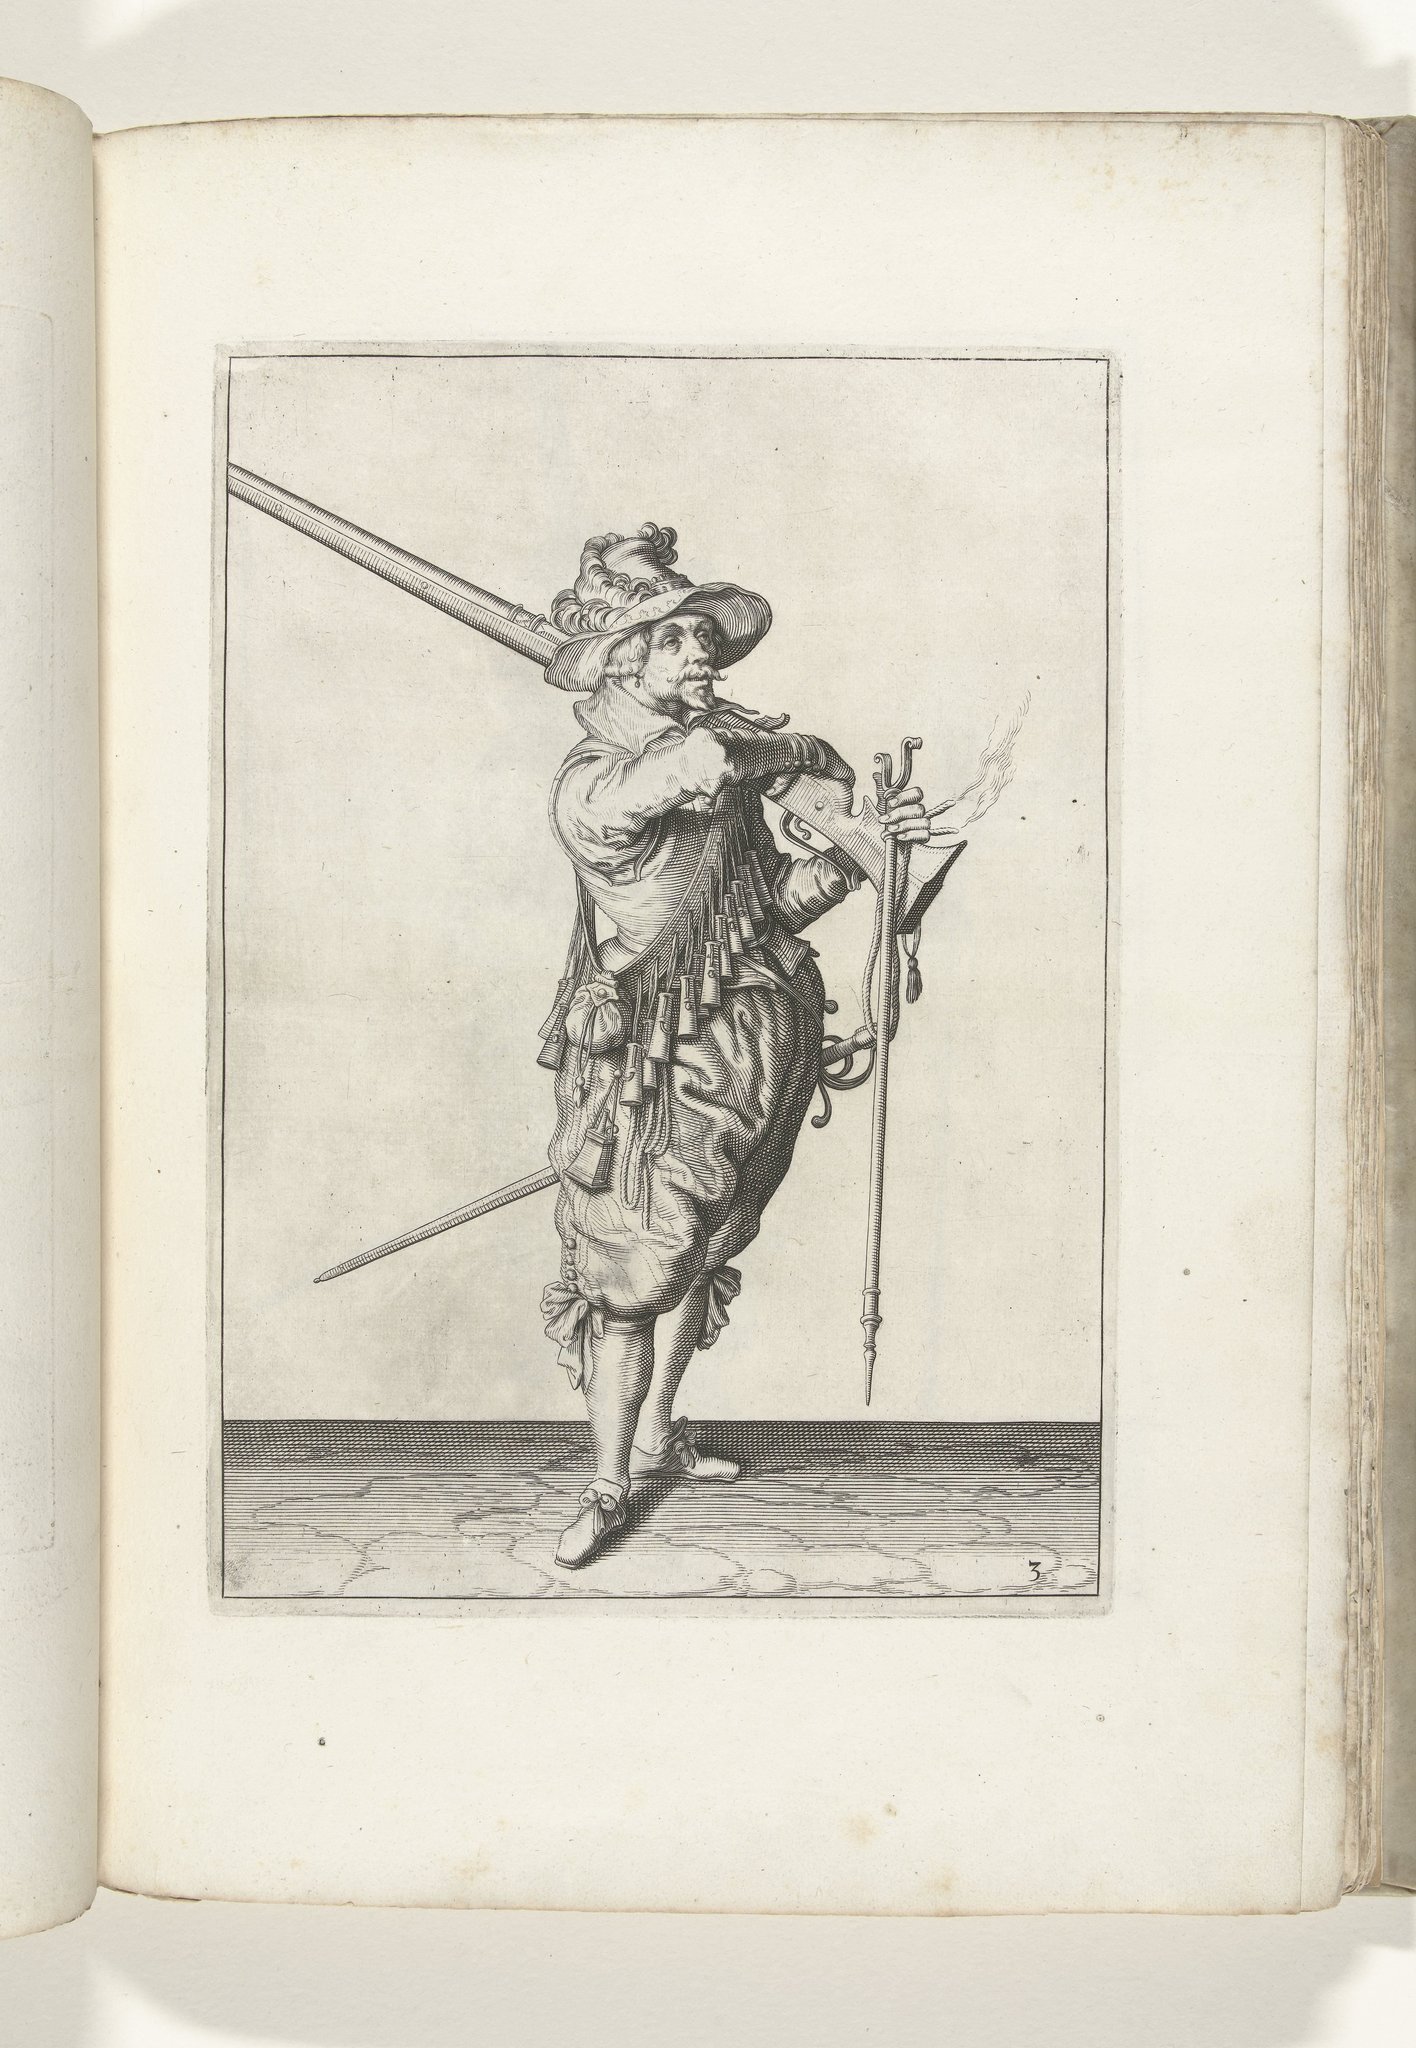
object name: print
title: Soldaat die zijn musket van zijn schouder neemt (nr. 3), ca. 1600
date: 1597-1607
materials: paper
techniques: engraving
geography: northern netherlands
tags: the hague, maurice (prince of orange), handling of weapons ~ military training, weapons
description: Een soldaat, ten voeten uit, naar rechts, die een musket (een bepaald type vuurwapen) van zijn linkerschouder neemt met zijn rechterhand (nr. 3), ca. 1600. In zijn linkerhand behalve de kolf van het musket ook een furket (musketvork) en een brandende lont. Plaat 3 in de instructies voor het hanteren van het musket: Corte onderrechtinghe op de figuerliicke afbeeldinghe, soo veel aengaet het recht ghebruyck vant Musquet. Onderdeel van de illustraties in: J. de Gheyn, Wapenhandelinghe van Roers Musquetten ende spiessen, 's-Gravenhage, 1607. Krijgswezen rond 1600.